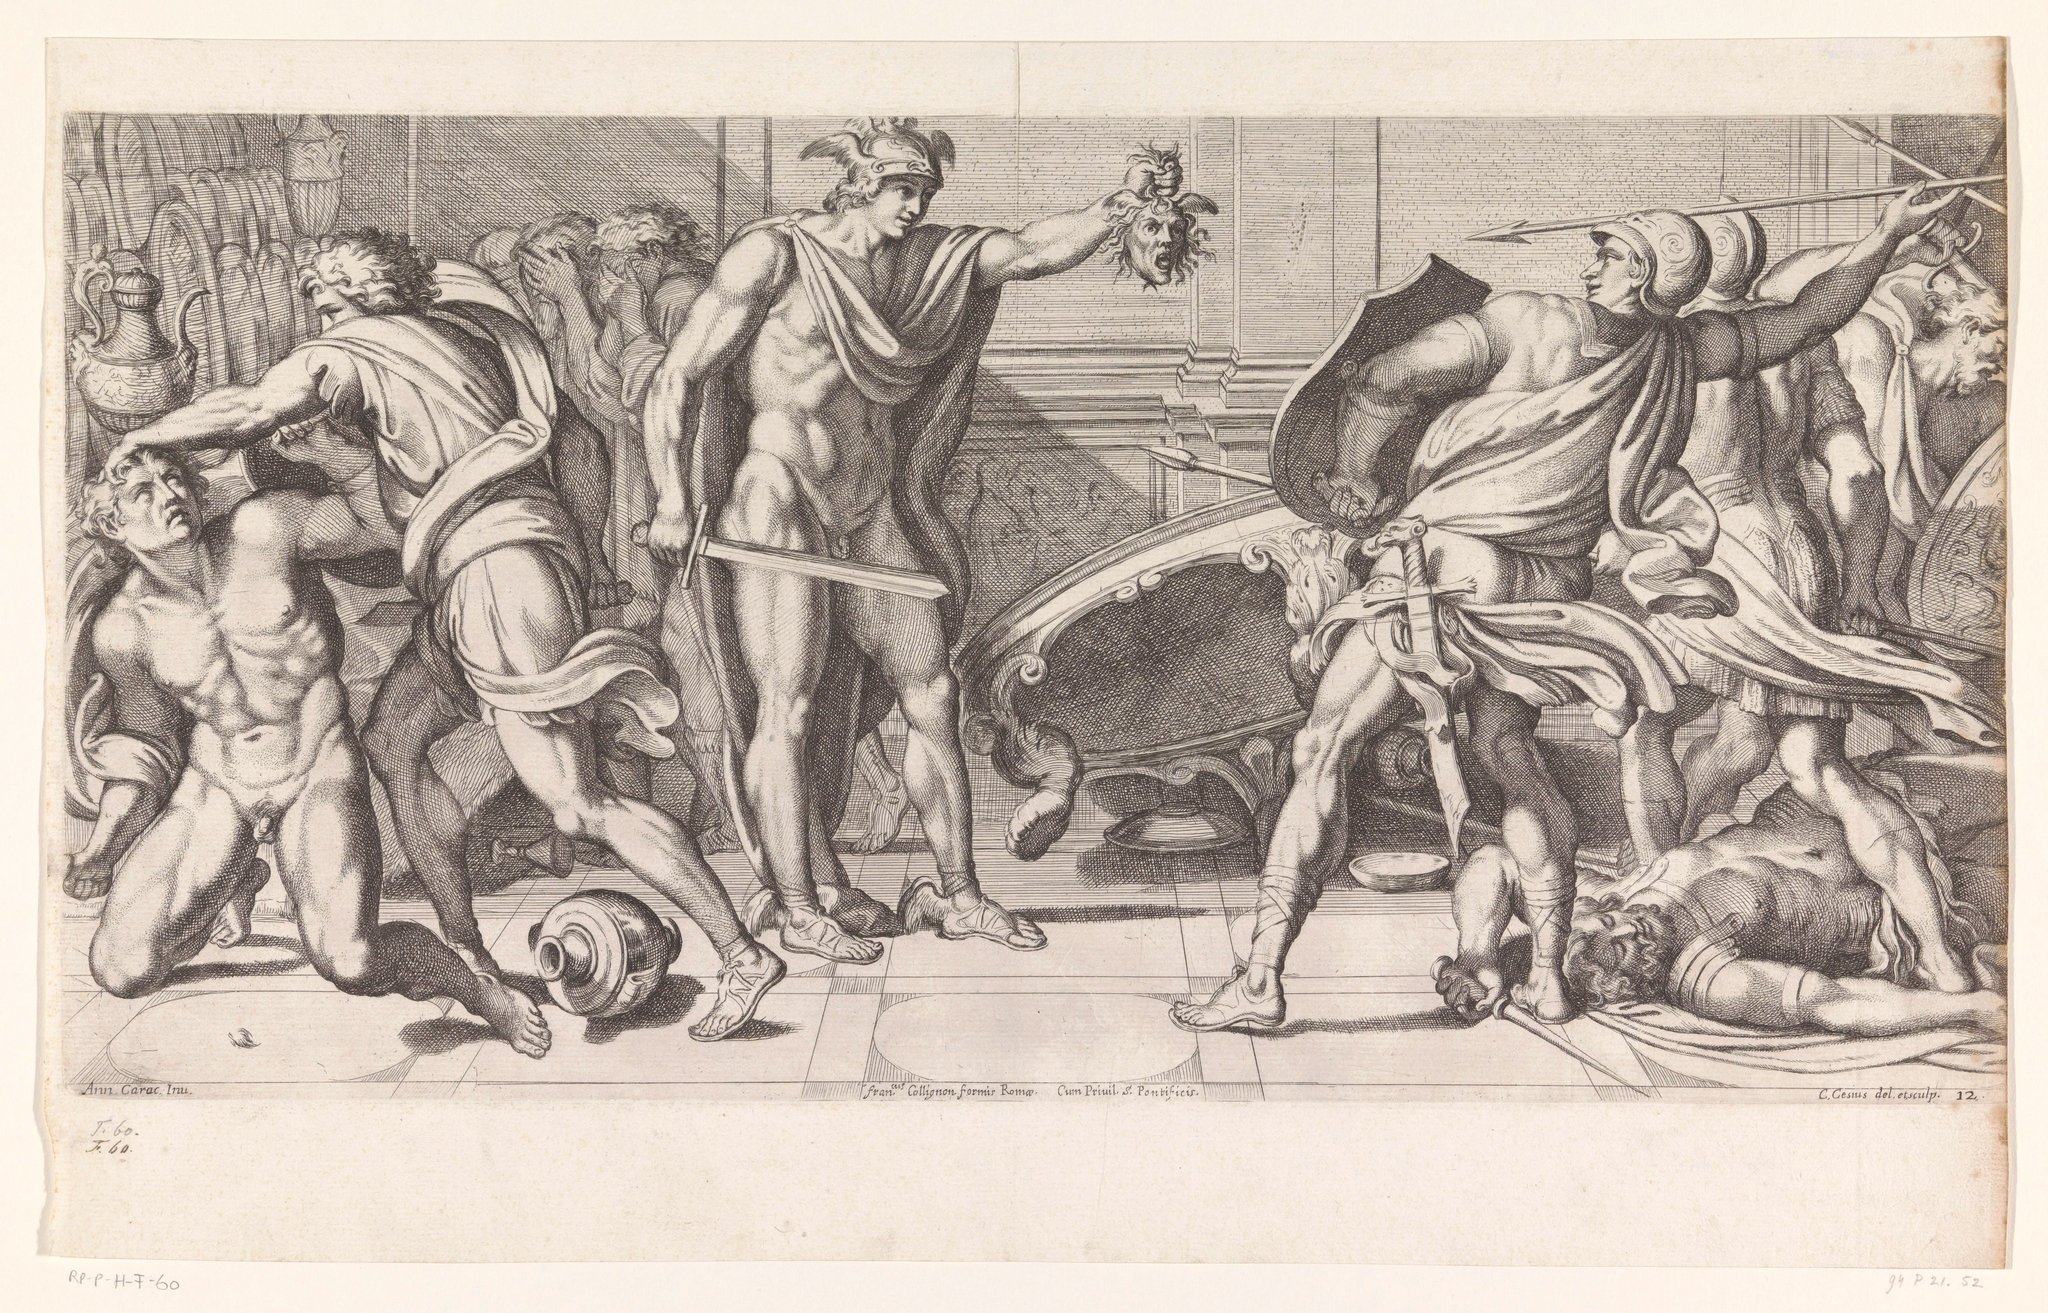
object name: print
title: Phineus en zijn volgelingen in steen veranderd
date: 1656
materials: paper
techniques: etching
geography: italy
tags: phineus and his attendants are turned into stone, the wedding-feast of perseus and andromeda is interrupted by phineus, a former suitor; a fight ensues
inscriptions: collector's mark: ‘Hinloopen’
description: Prent uit een reeks prenten met nummers van 1 tot en met 29 (sommige prenten hebben hetzelfde nummer), plus titelprent en opdracht, naar schilderingen in Palazzo Farnese te Rome. Deze prent maakte oorspronkelijk deel uit van liber nr. 22 van de Atlas van Rome, uit de collectie Hinloopen. In dit album waren een aantal prentreeksen naar bekende zeventiende eeuwse frescoseries bijeengebonden. In 1709 heeft Schijnvoet op last van de burgemeesters van Amsterdam de collectie herordend. De prenten uit liber 22 kwamen terrecht in Schijnvoet boek nr. 10. De laatst gedateerde reeks in het album is gedateerd 1691. Het album moet dus na deze datum gebonden zijn. De band is in de Rijksakademietijd uit elkaar gehaald. De marges van de prenten zijn bij het opbergen in het Rijksprentenkabinet vaak drastisch afgesneden. Van een aantal series waren de prenten teruggeslagen om in het album te passen. (Zie: Waals, Jan van der. De prentschat van Michiel Hinloopen. 's-Gravenhage: SDU uitgeverij, 1988, pp. 173-174.)